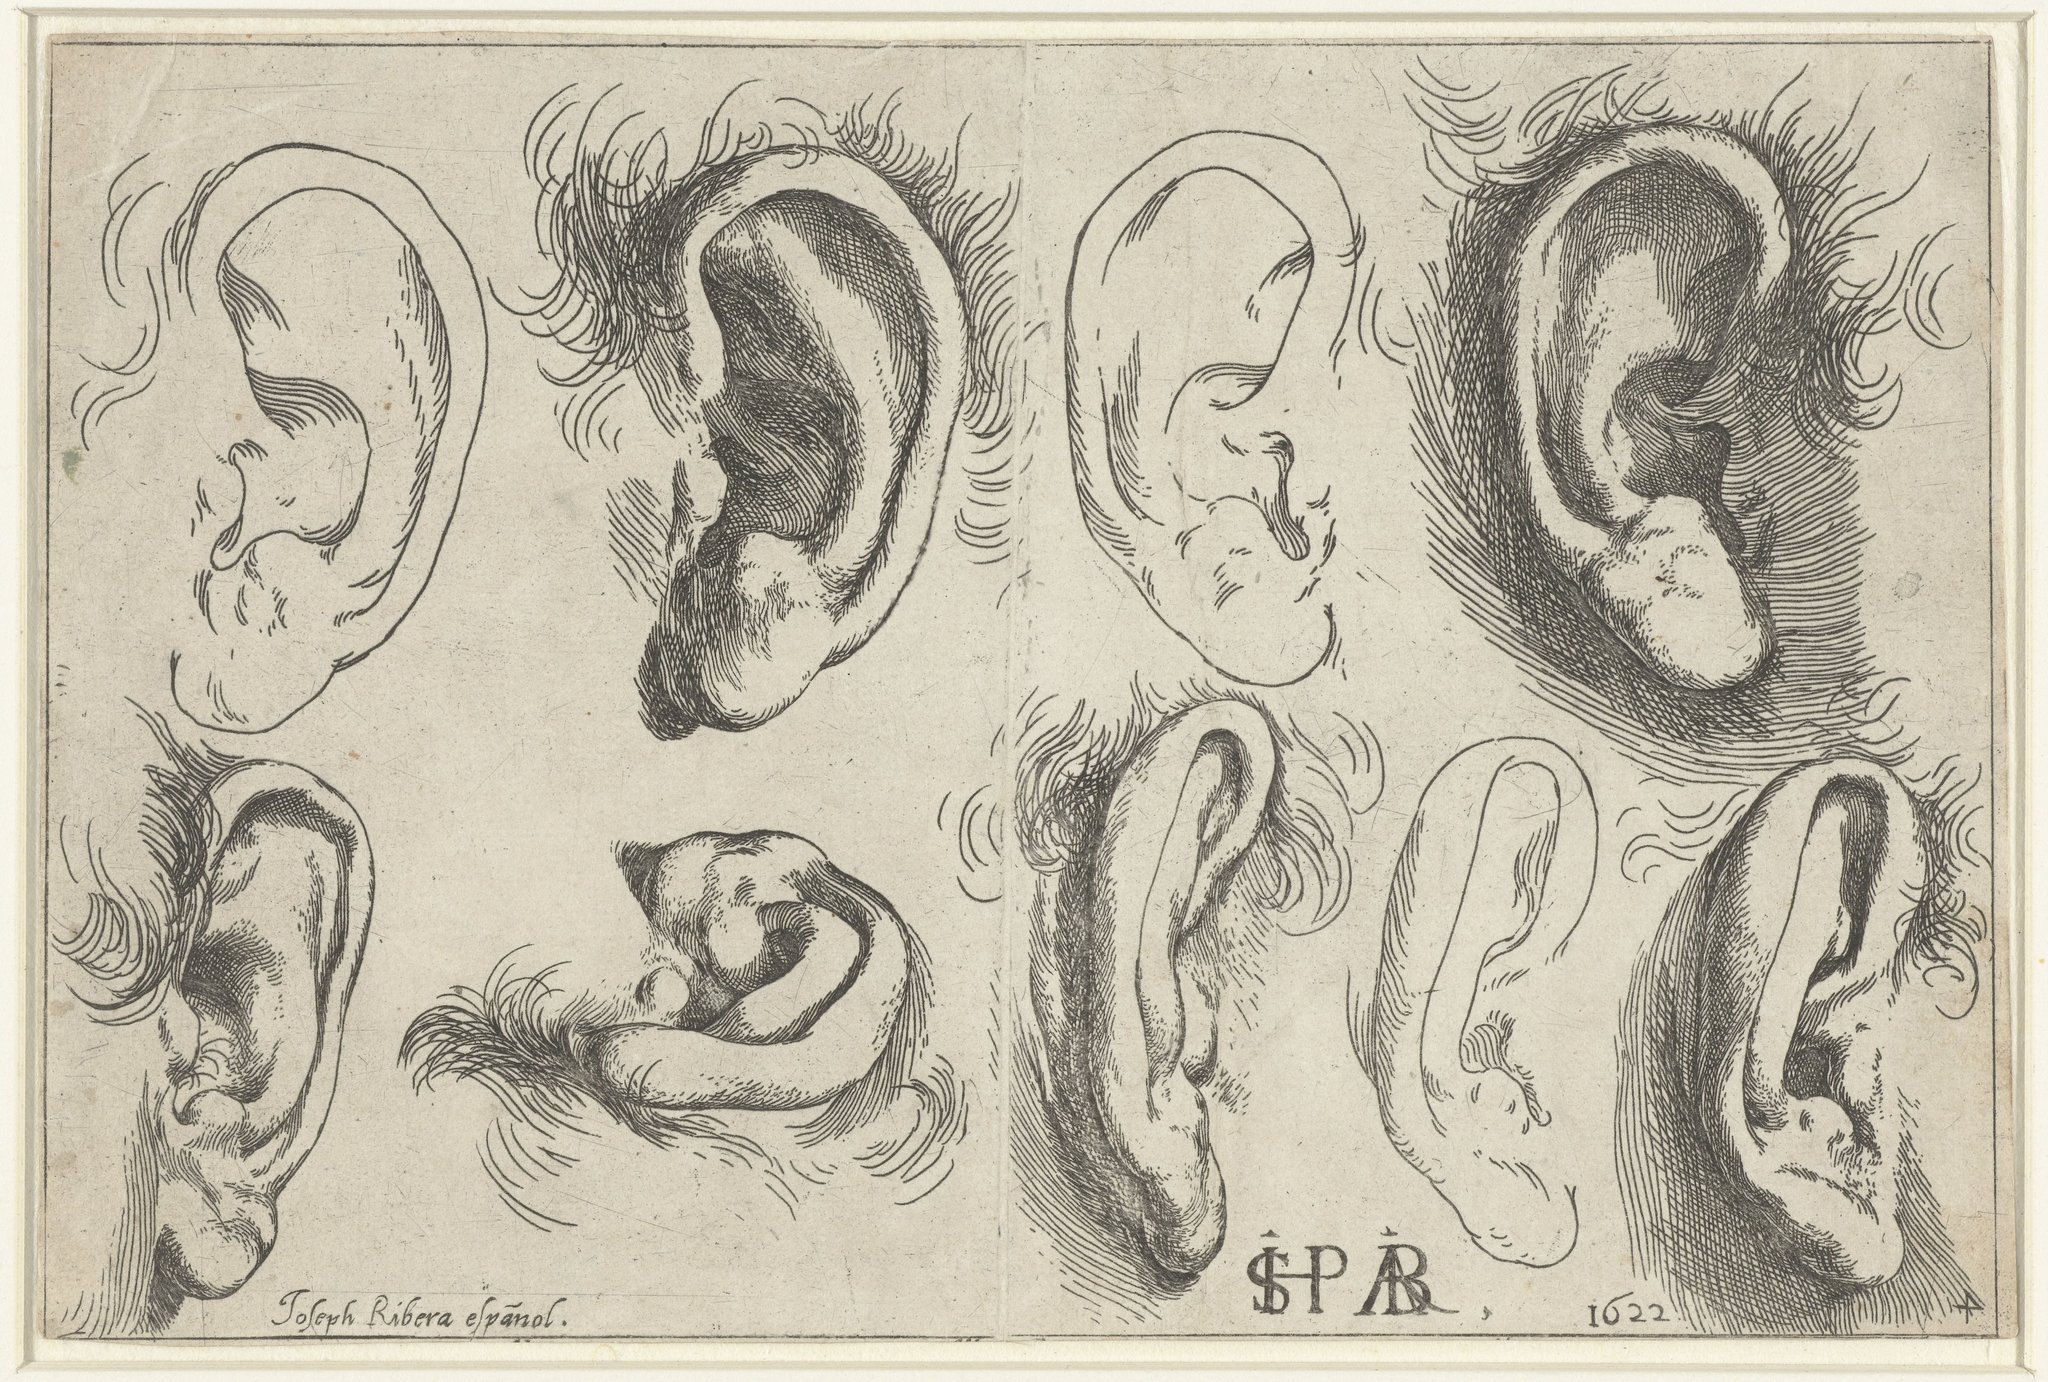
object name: print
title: Studies van oren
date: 1622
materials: paper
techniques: etching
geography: low countries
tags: ears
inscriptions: number: ‘4’, collector's mark: Lugt 240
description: Verschillende studies van menselijke oren.